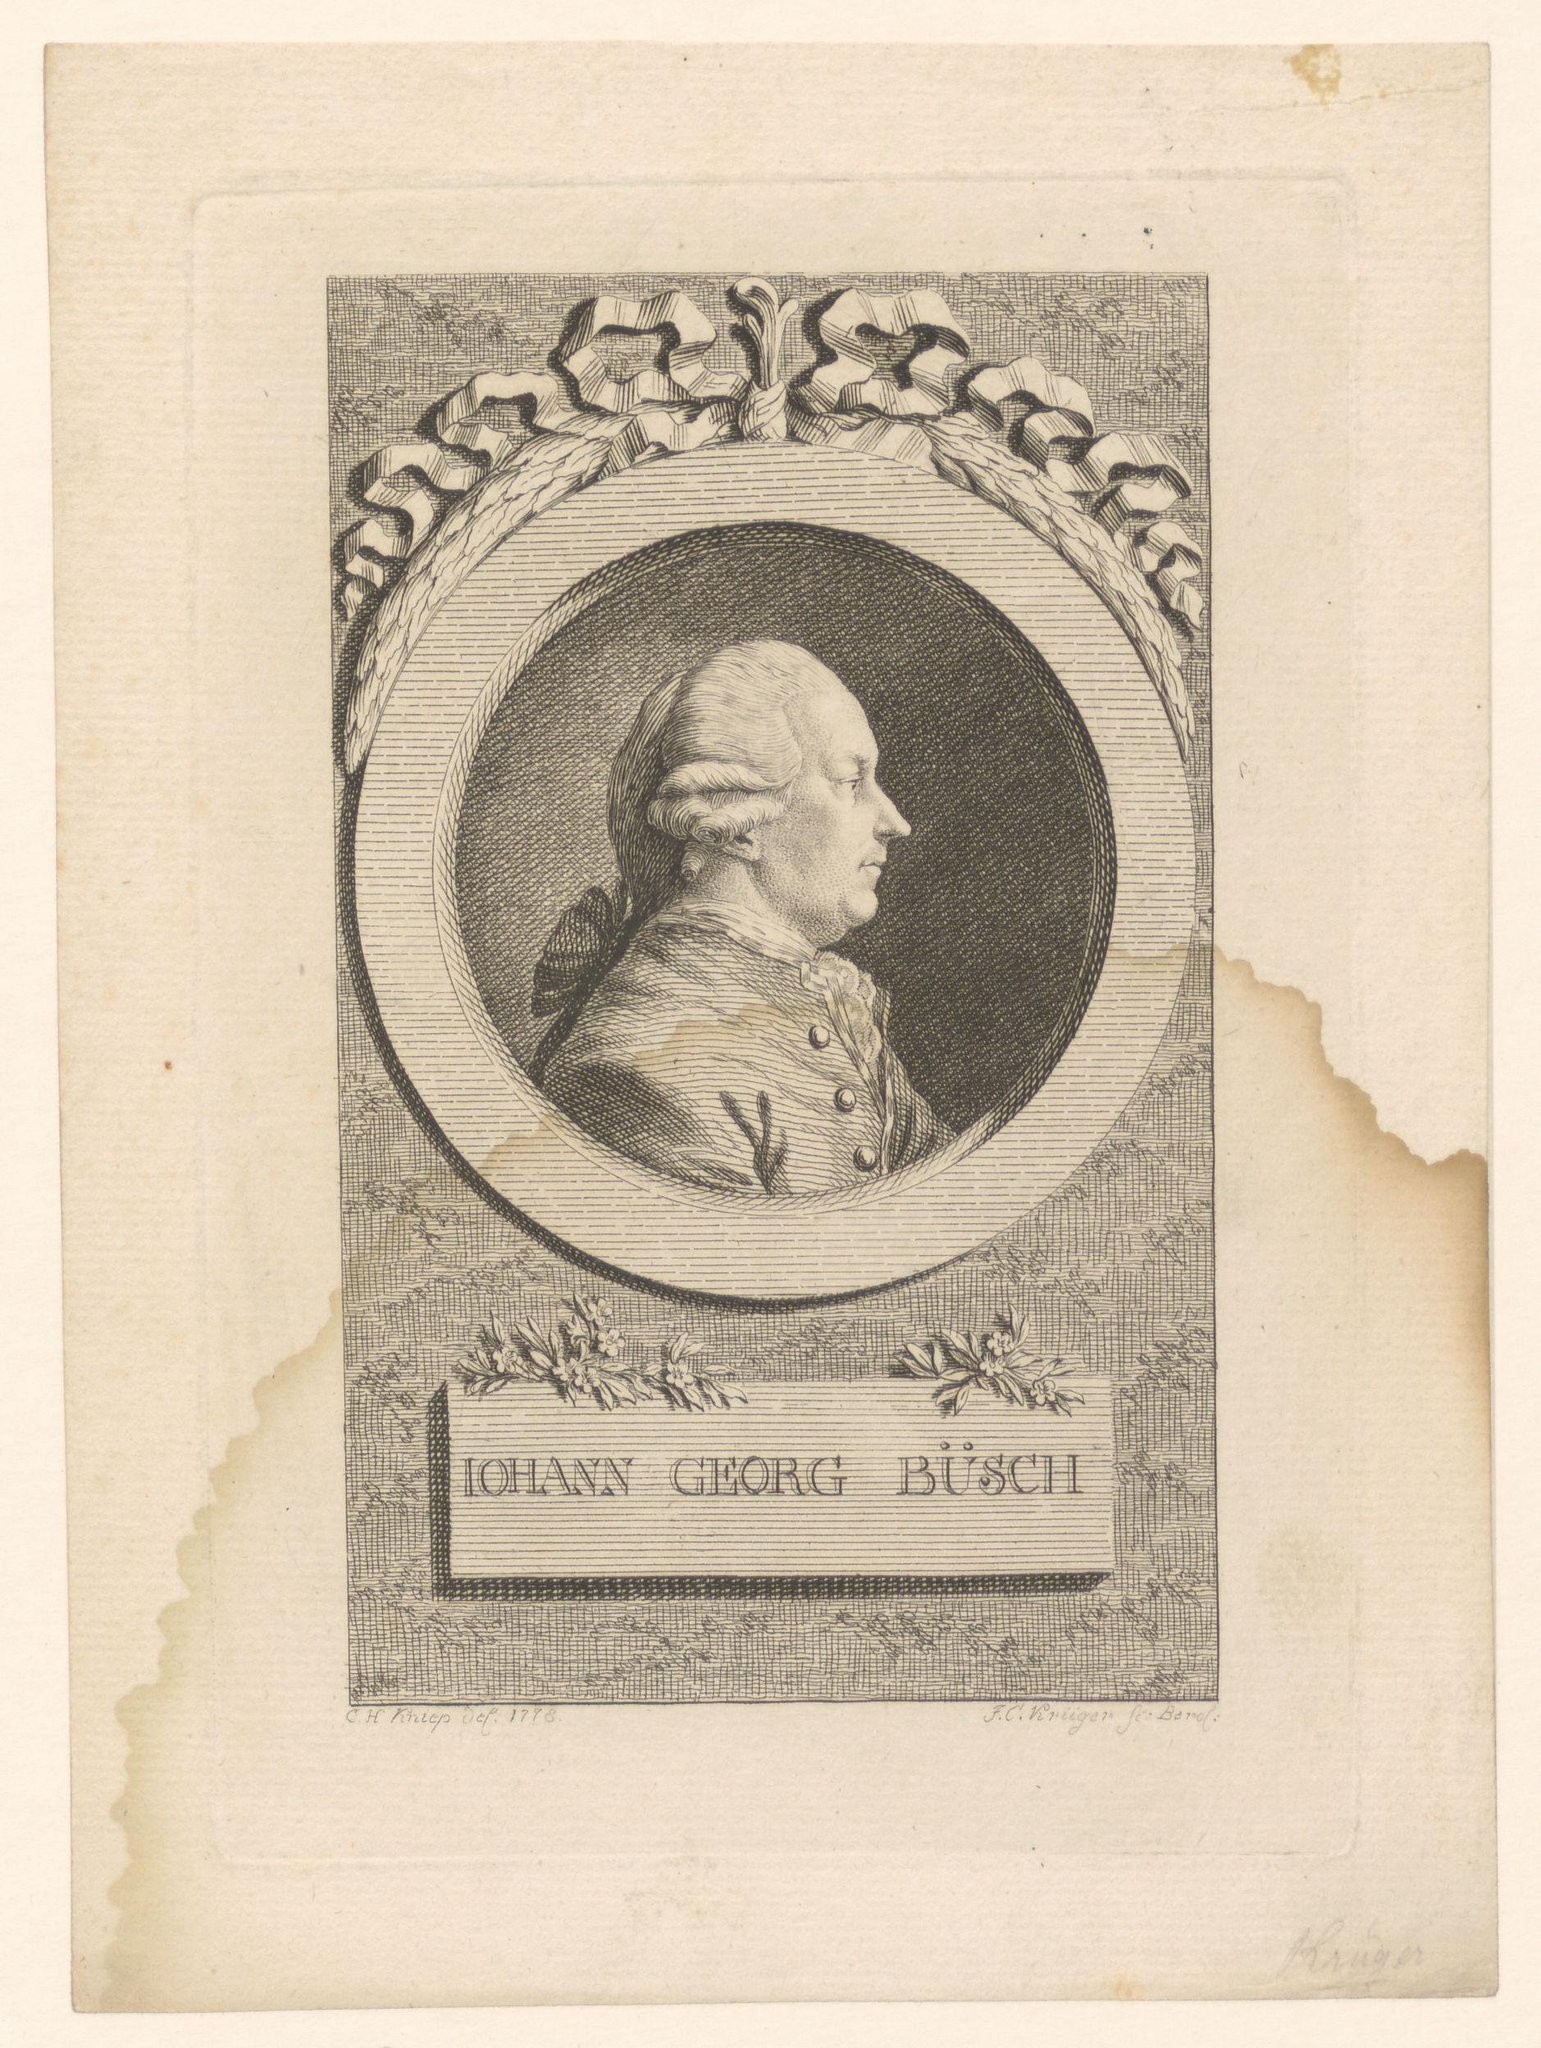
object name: print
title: Portret van Johann Georg Büsch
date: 1784-1791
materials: paper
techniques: engraving, etching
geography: berlin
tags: germany, further education (+ portrait of teacher, professor), historical persons, mathematics (+ portrait of scholar, scientist)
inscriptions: collector's mark: Lugt 2228